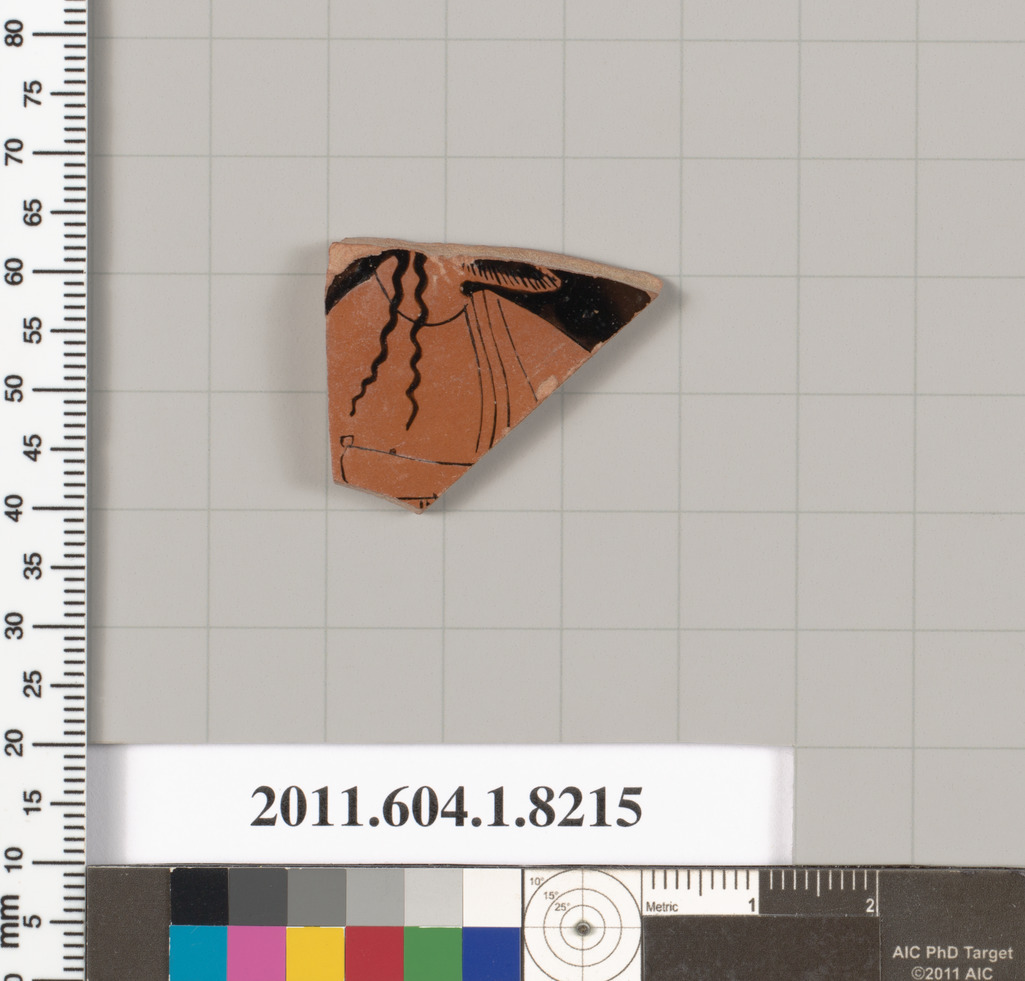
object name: kylix fragment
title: Terracotta fragment of a kylix (drinking cup)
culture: greek, attic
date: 520-510 BCE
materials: terracotta